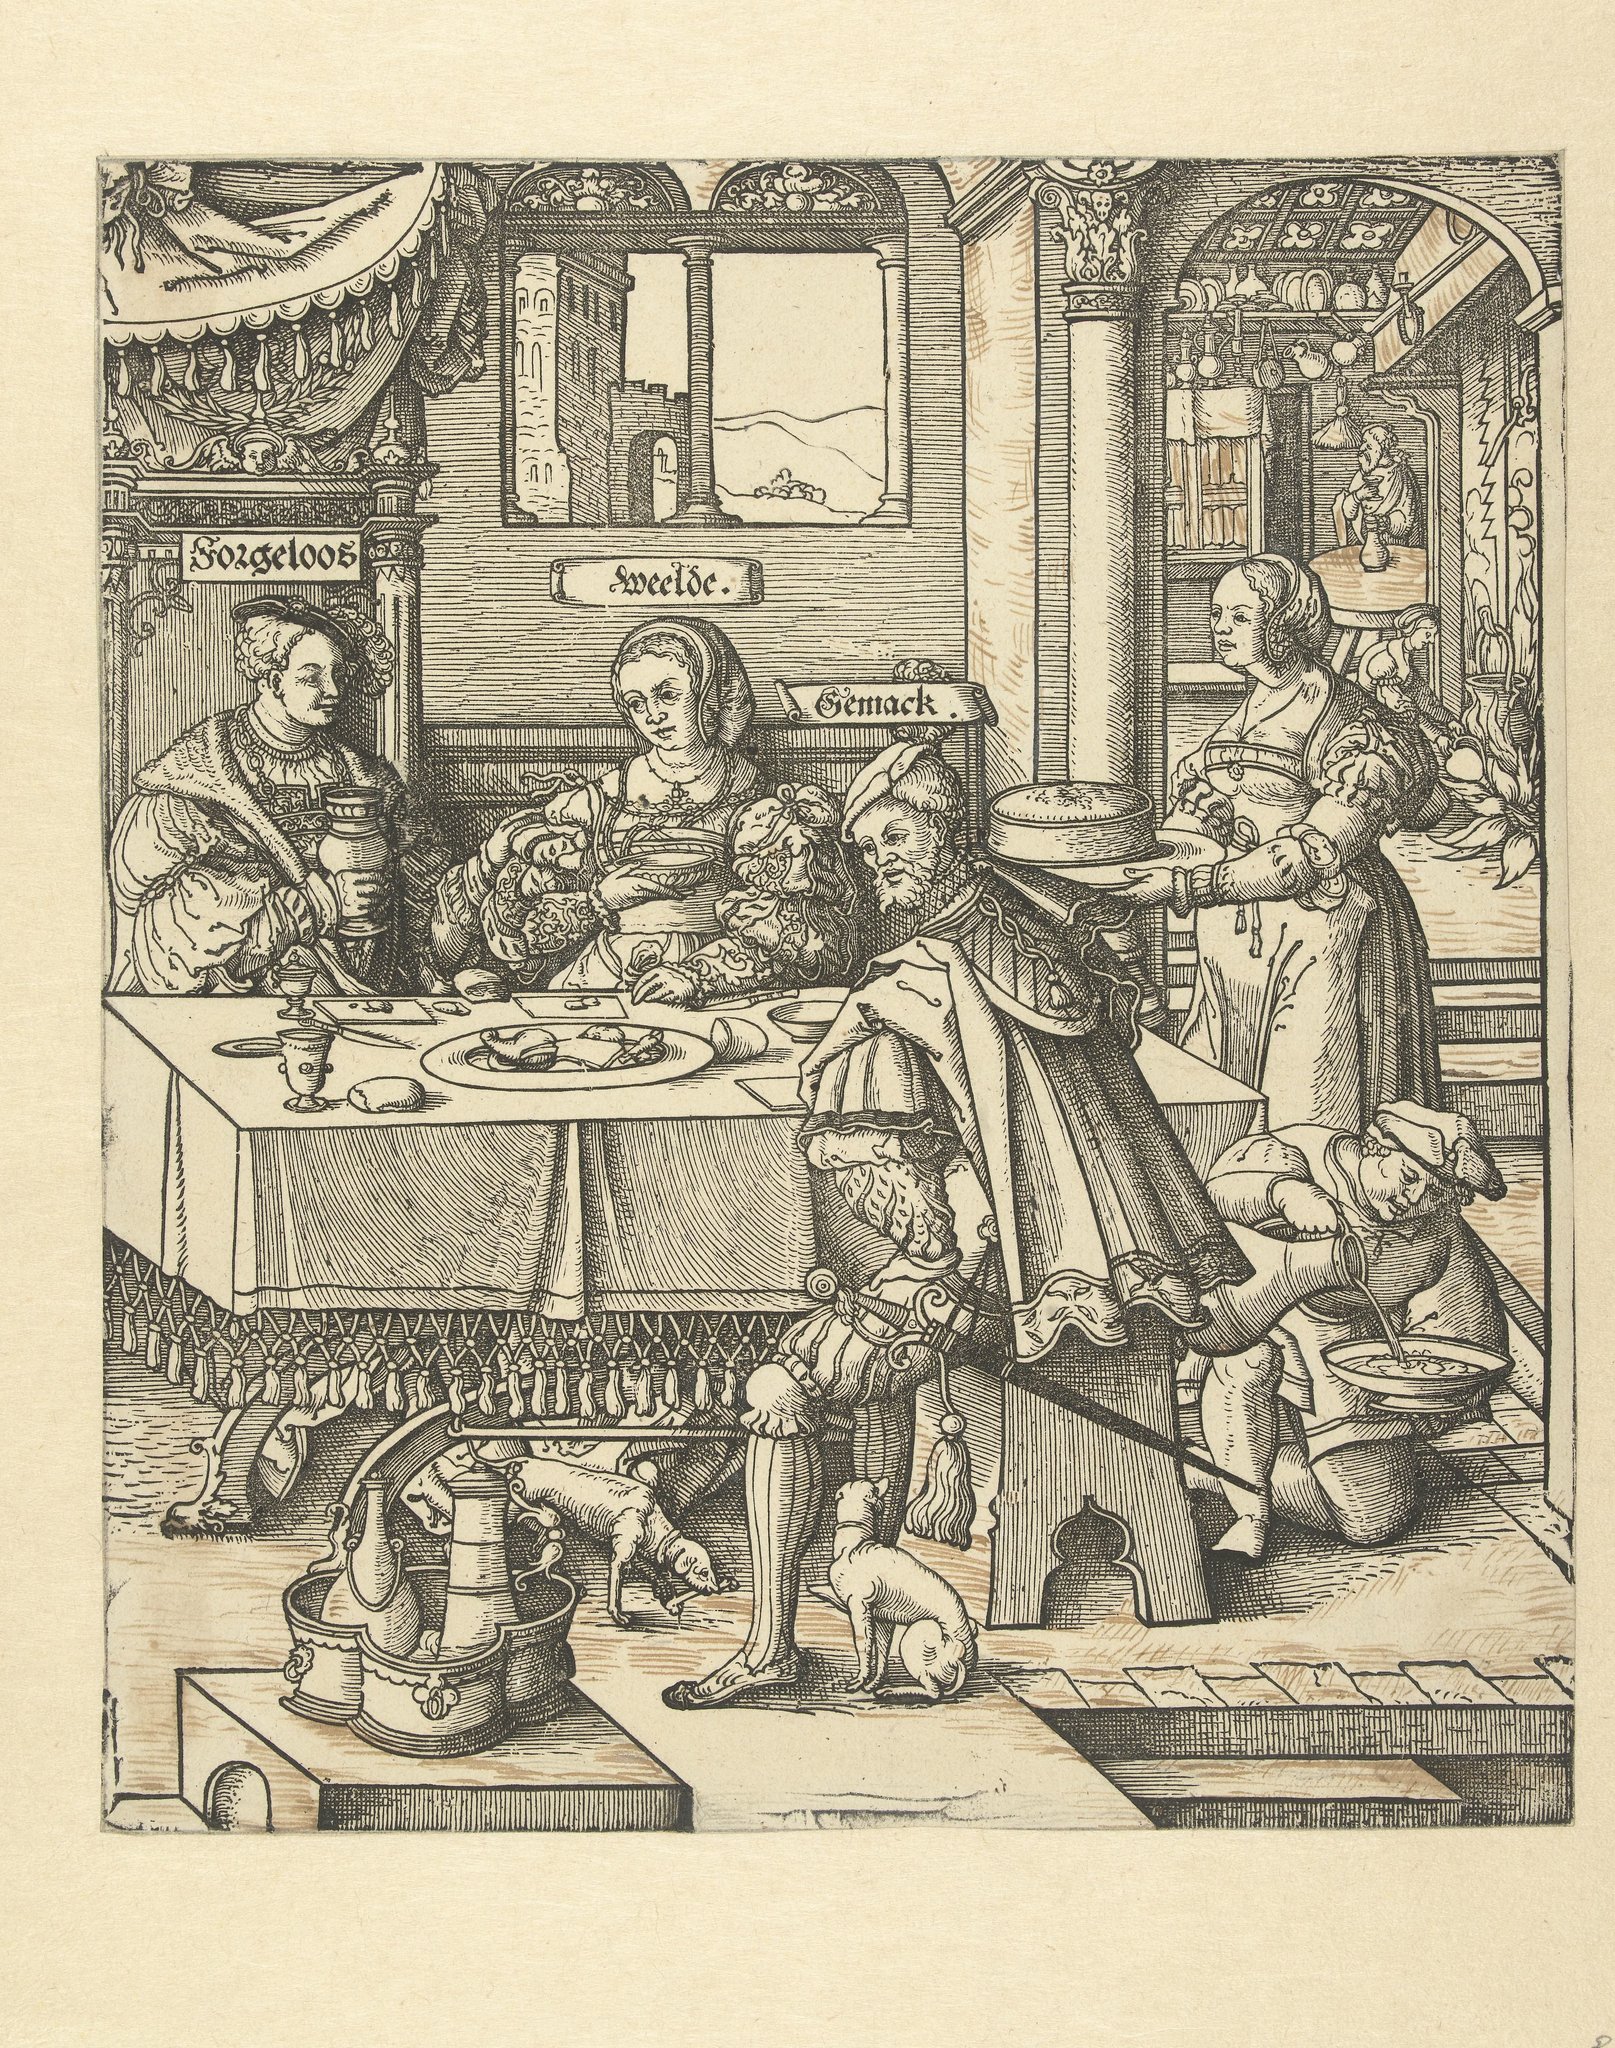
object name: print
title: Het verhaal van Sorgheloos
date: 1541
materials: paper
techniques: pen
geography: low countries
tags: carelessness, wealth, opulence; 'opulenza', 'richezza' (ripa), (family) meal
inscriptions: collector's mark: Lugt 240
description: Eén van serie van zes. Sorgheloos etend en drinkend aan tafel met Weelde en Gemack. Zonder bijbehorende omlijsting en tekst.